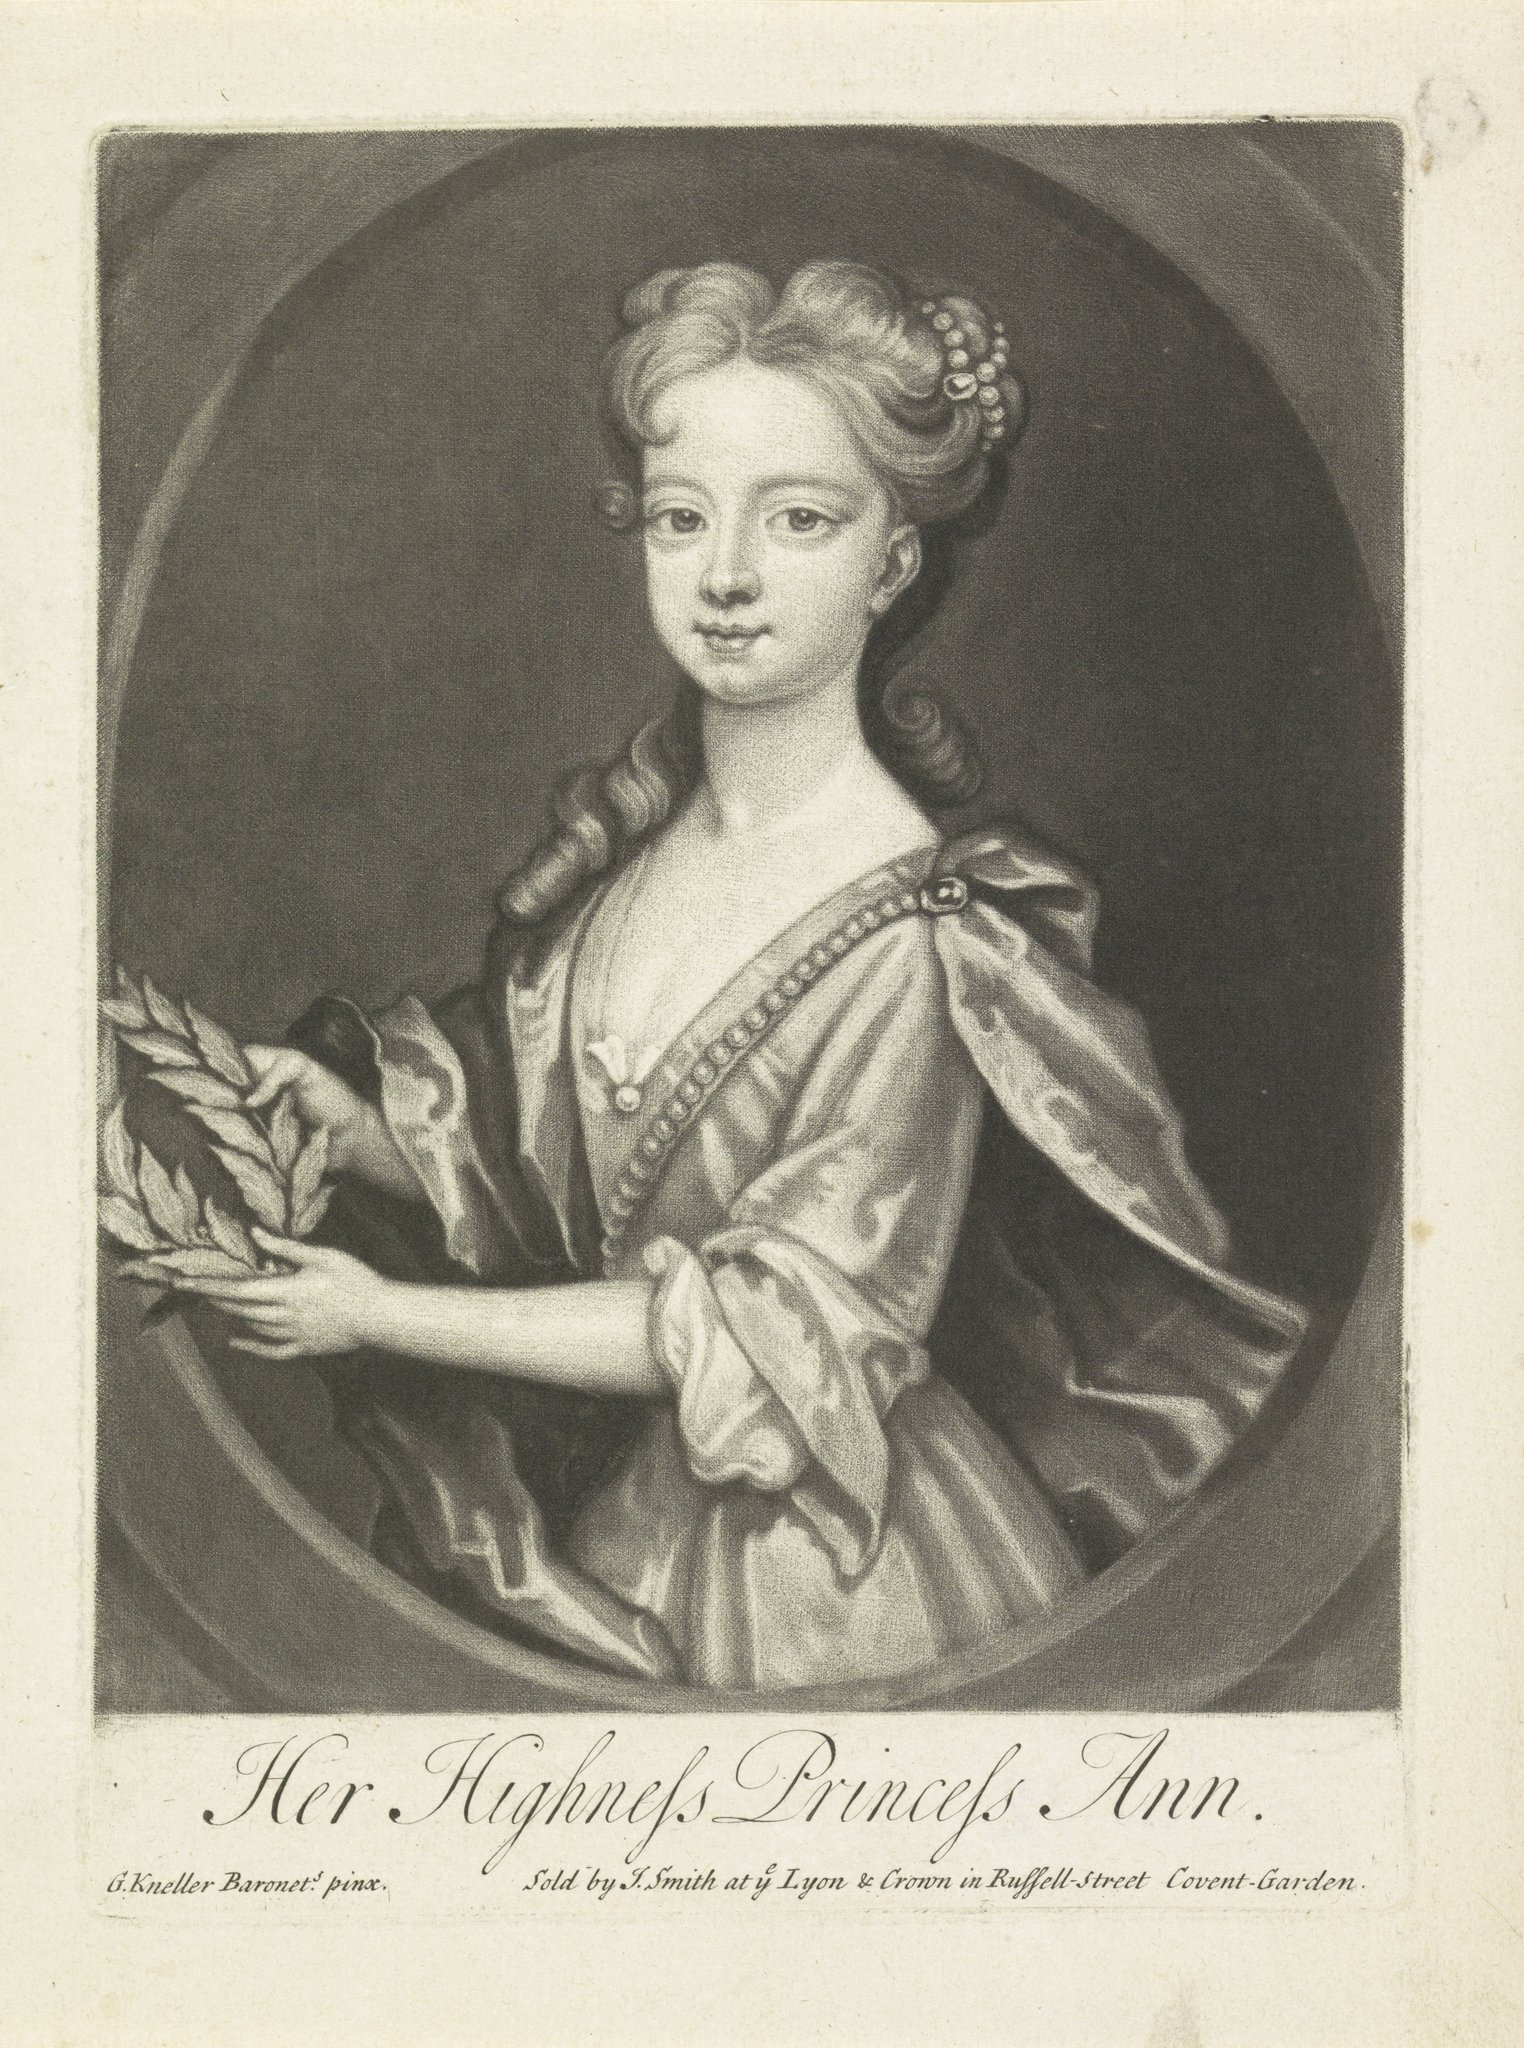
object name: print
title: Portret van Anna van Hannover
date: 1715-1743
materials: paper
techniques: mezzotint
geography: london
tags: the hague, anna van hannover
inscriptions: collector's mark: Lugt 240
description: Portret van Anna in een ovaal. In haar handen een lauwerkrans. In de ondermarge haar naam en titel.